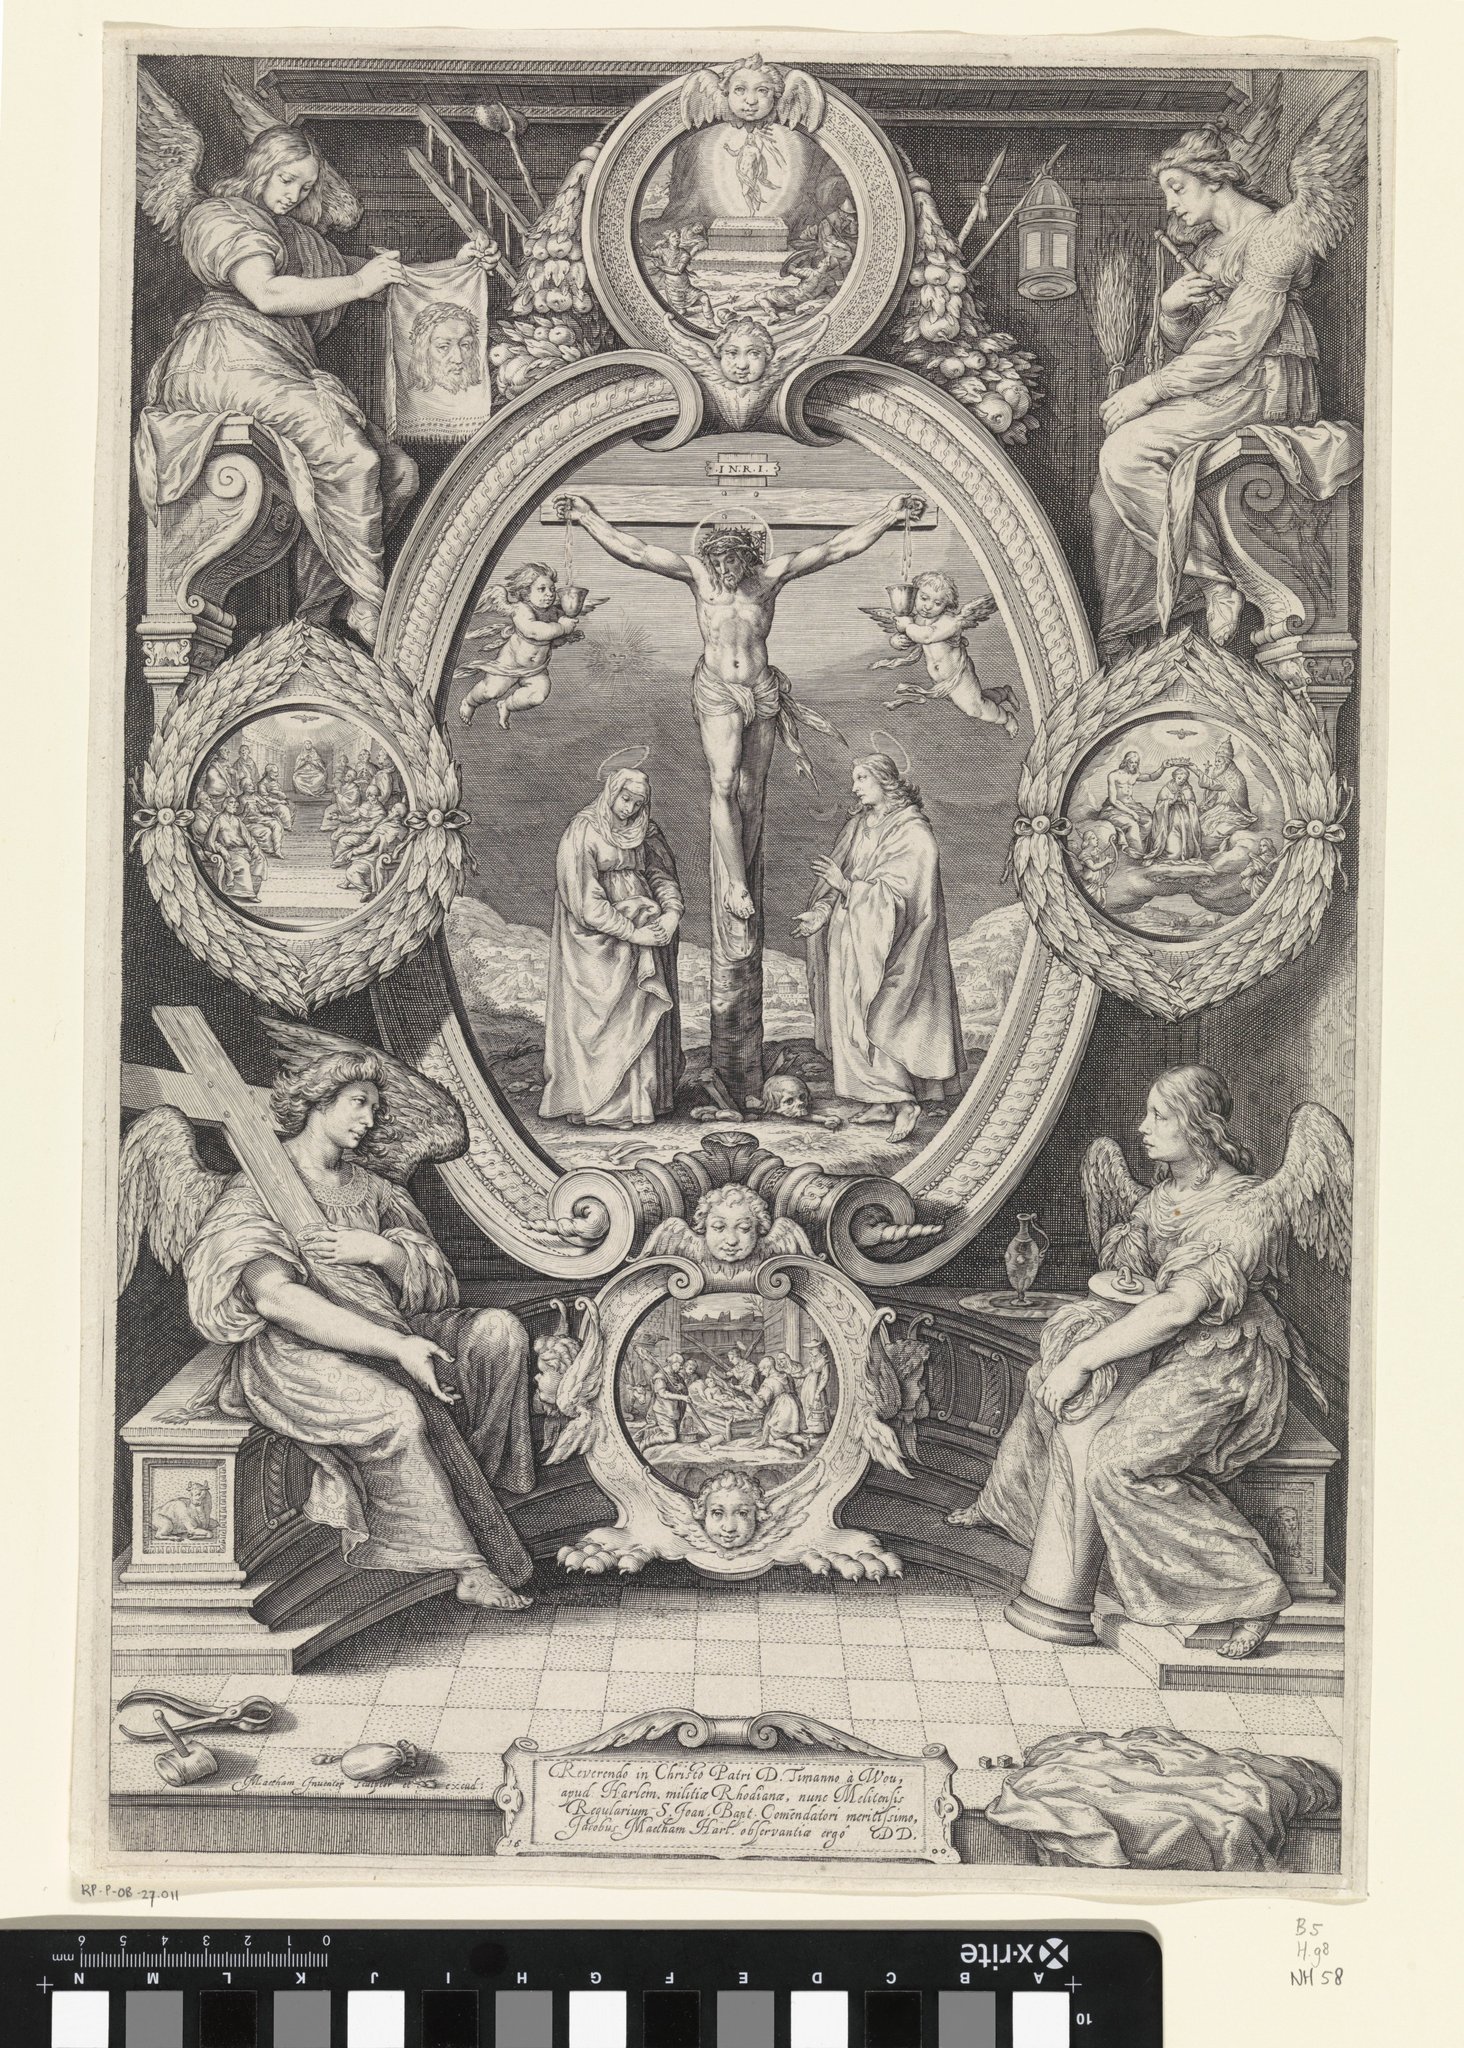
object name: print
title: Kruisiging met Maria en Johannes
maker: jacob matham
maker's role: draughtsman, print maker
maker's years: 1571-1631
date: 1600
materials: paper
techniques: engraving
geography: haarlem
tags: 'arma christi', crucified christ with mary and john on either side of the cross; holy rood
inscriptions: signature and address: ‘J.Maetham Inventor sculptor et excud.’, collector's mark: Lugt 240, caption: ‘Reverendo in Christo Patri...’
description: Kruisiging met Maria en Johannes, in ovaal cartouche met vier voorstellingen in medaillons: bovenaan de Opstanding, links de Uitstorting van de Heilige Geest, rechts de Kroning van Maria en onderaan de Geboorte van Christus. Hieromheen vier engelen met passie-instrumenten en de Veronicadoek.